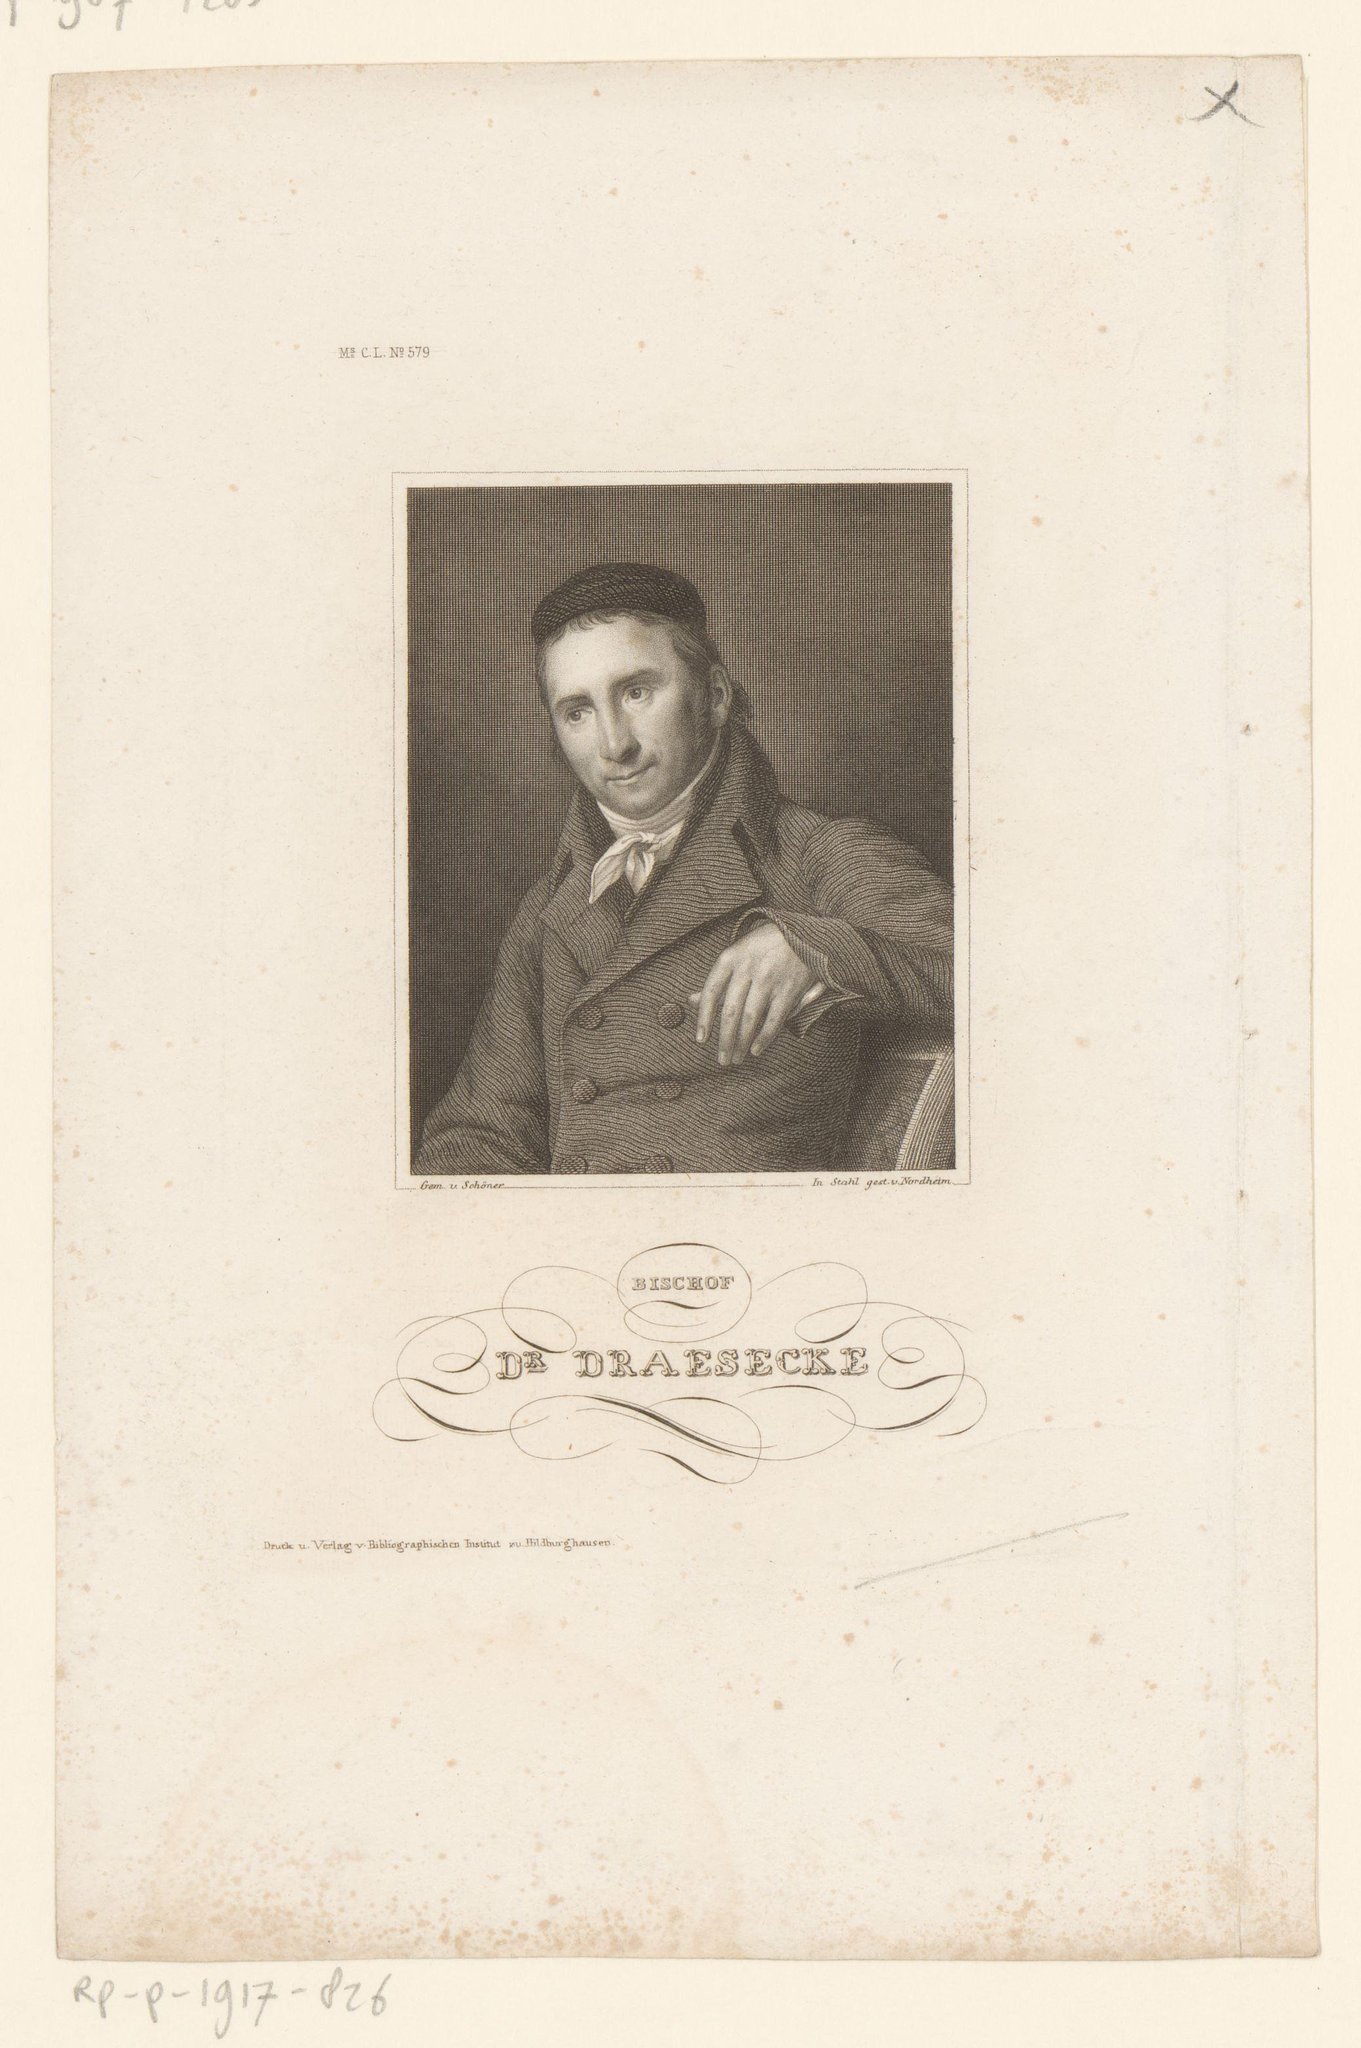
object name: book illustration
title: Portret van Johann Heinrich Bernhard Dräseke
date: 1840-1855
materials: paper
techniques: etching, engraving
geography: hildburghausen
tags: historical persons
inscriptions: collector's mark: Lugt 2228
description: Prent afkomstig uit: Conversations-Lexikon für die gebildeten Stände, voor het eerst uitgegeven tussen 1840-1855.